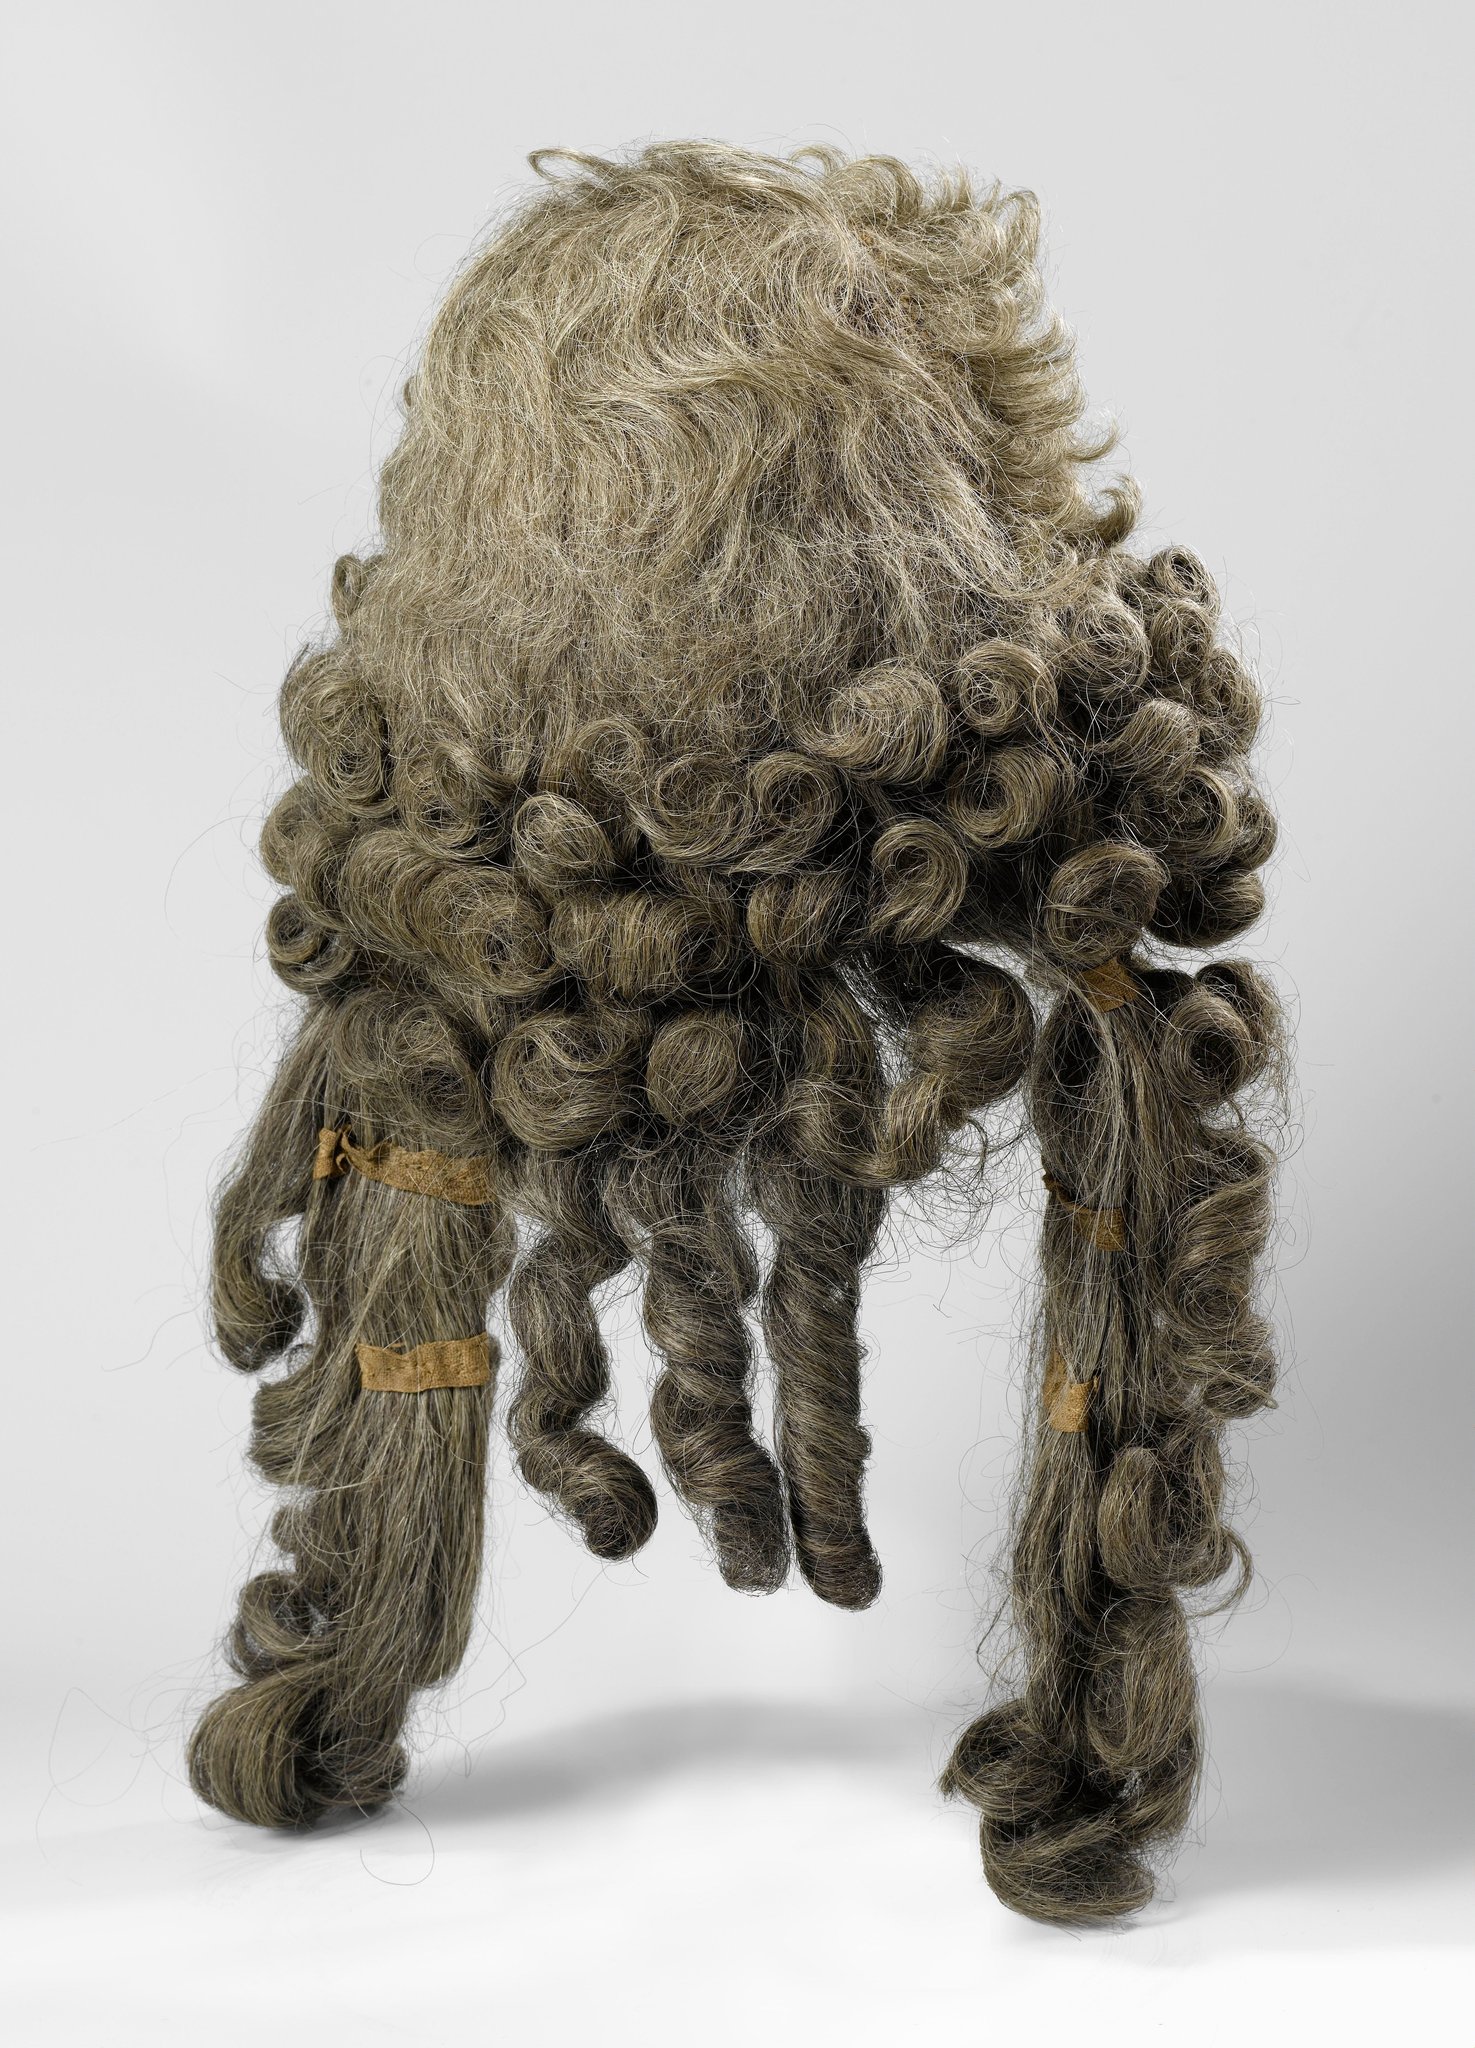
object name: peruke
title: Shoulder-Length, Curled, and Powdered Allonge Wig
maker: Anonymous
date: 1700-1720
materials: hair, linen, fiber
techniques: knotting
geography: netherlands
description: For many decades from the late 17th century on, it was fashionable for men of the elite to wear a wig to always show a full head of hair regardless of age. This wig is a rare and early example, with high fronts and cascading curls at the sides and back. The wig’s owner would have had it powdered almost entirely white before going out.